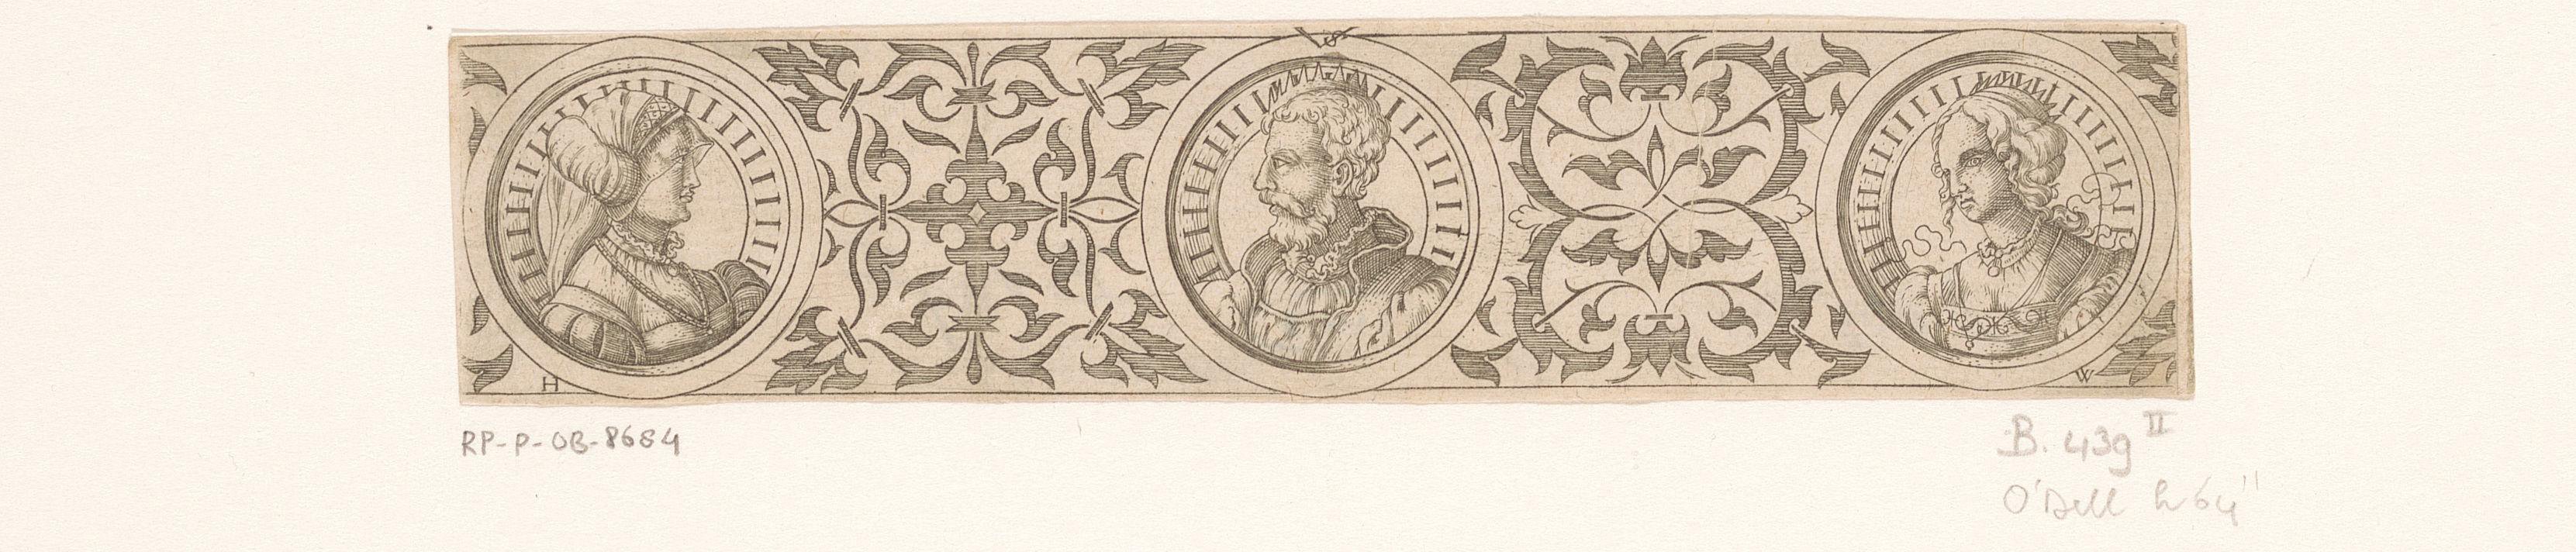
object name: ornament print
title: Fries met drie bustes in medaillons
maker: virgilius solis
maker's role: draughtsman, print maker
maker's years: 1514-1562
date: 1524-1562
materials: paper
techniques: engraving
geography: nuremberg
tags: chest, bust, ornament ~ arabesque, ornament ~ medallion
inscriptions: collector's mark: Lugt 2228, number: ‘15’